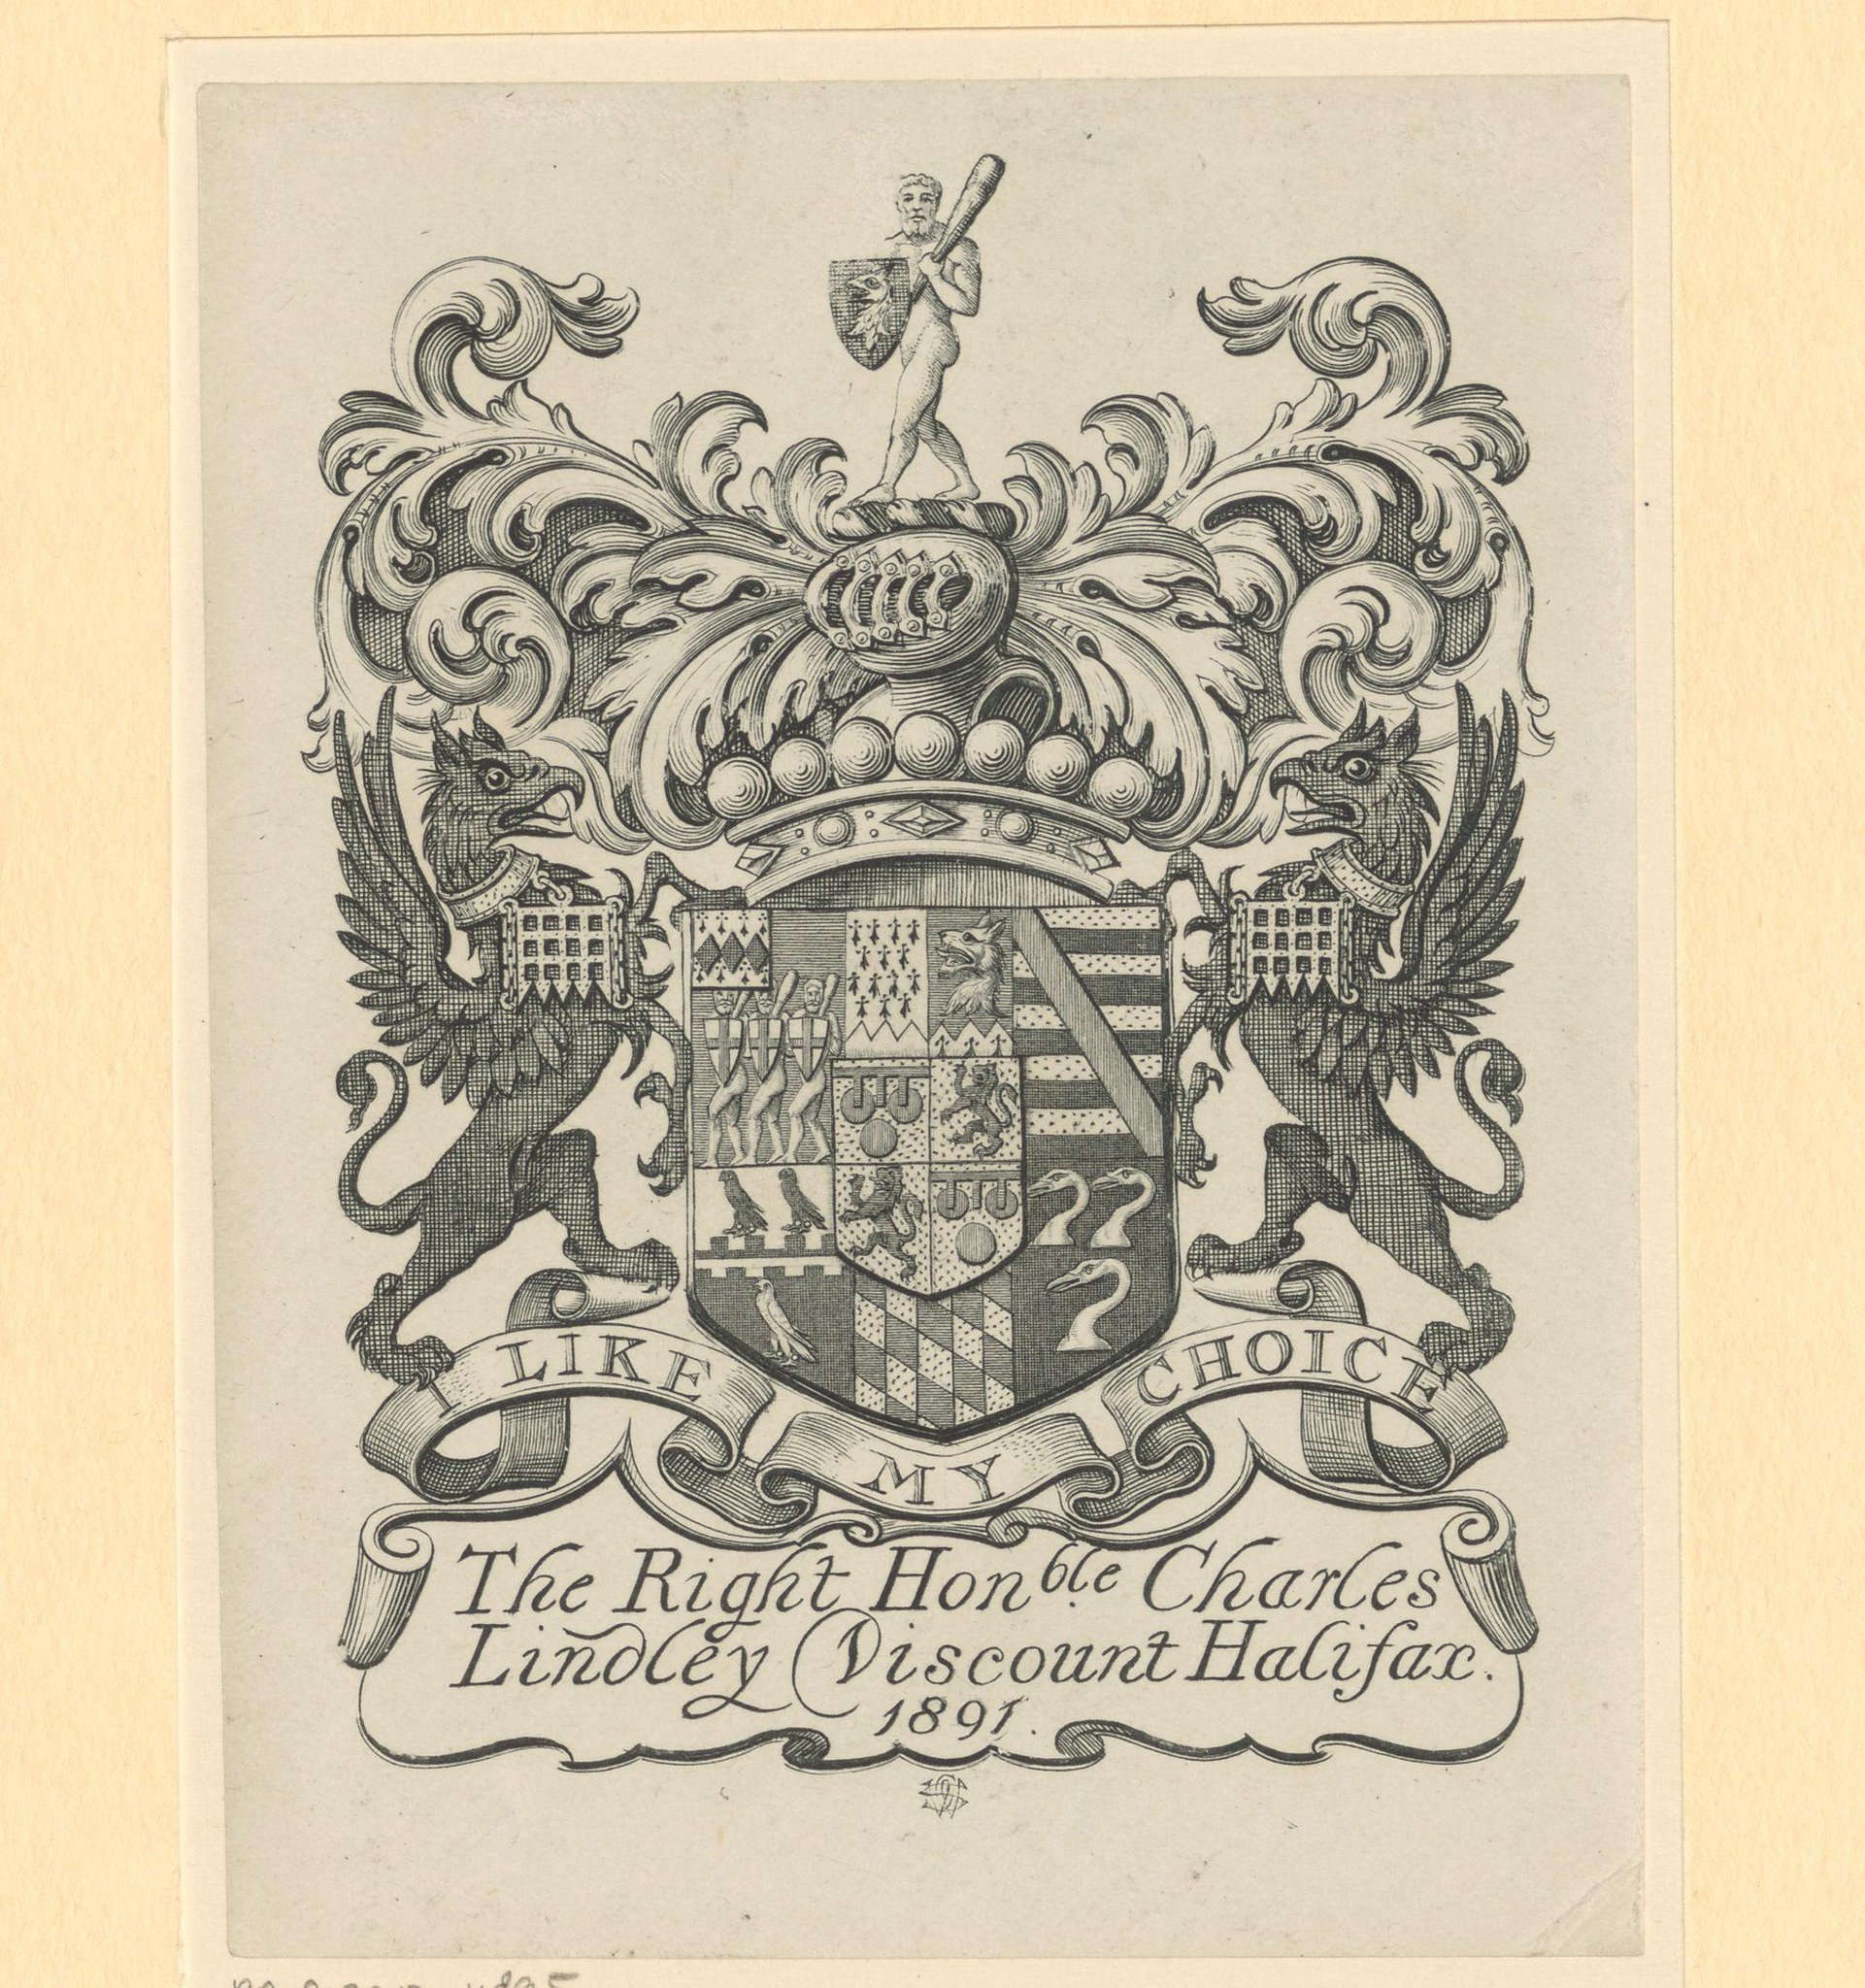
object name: bookplate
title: Ex libris van Charles Lindley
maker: charles william sherborn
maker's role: print maker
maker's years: 1831-1912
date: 1891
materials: paper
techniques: engraving, etching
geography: england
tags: griffin (lion/eagle); 'griffo' (ripa), weapons for striking a blow: club, armorial bearing, heraldry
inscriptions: date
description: Het schilderij "Vrouw bij het raam" van Johannes Vermeer was aan het eind van de negentiende eeuw in bezit van Joseph. Het bevindt zich tegenwoordig in The Frick Collection, New York.